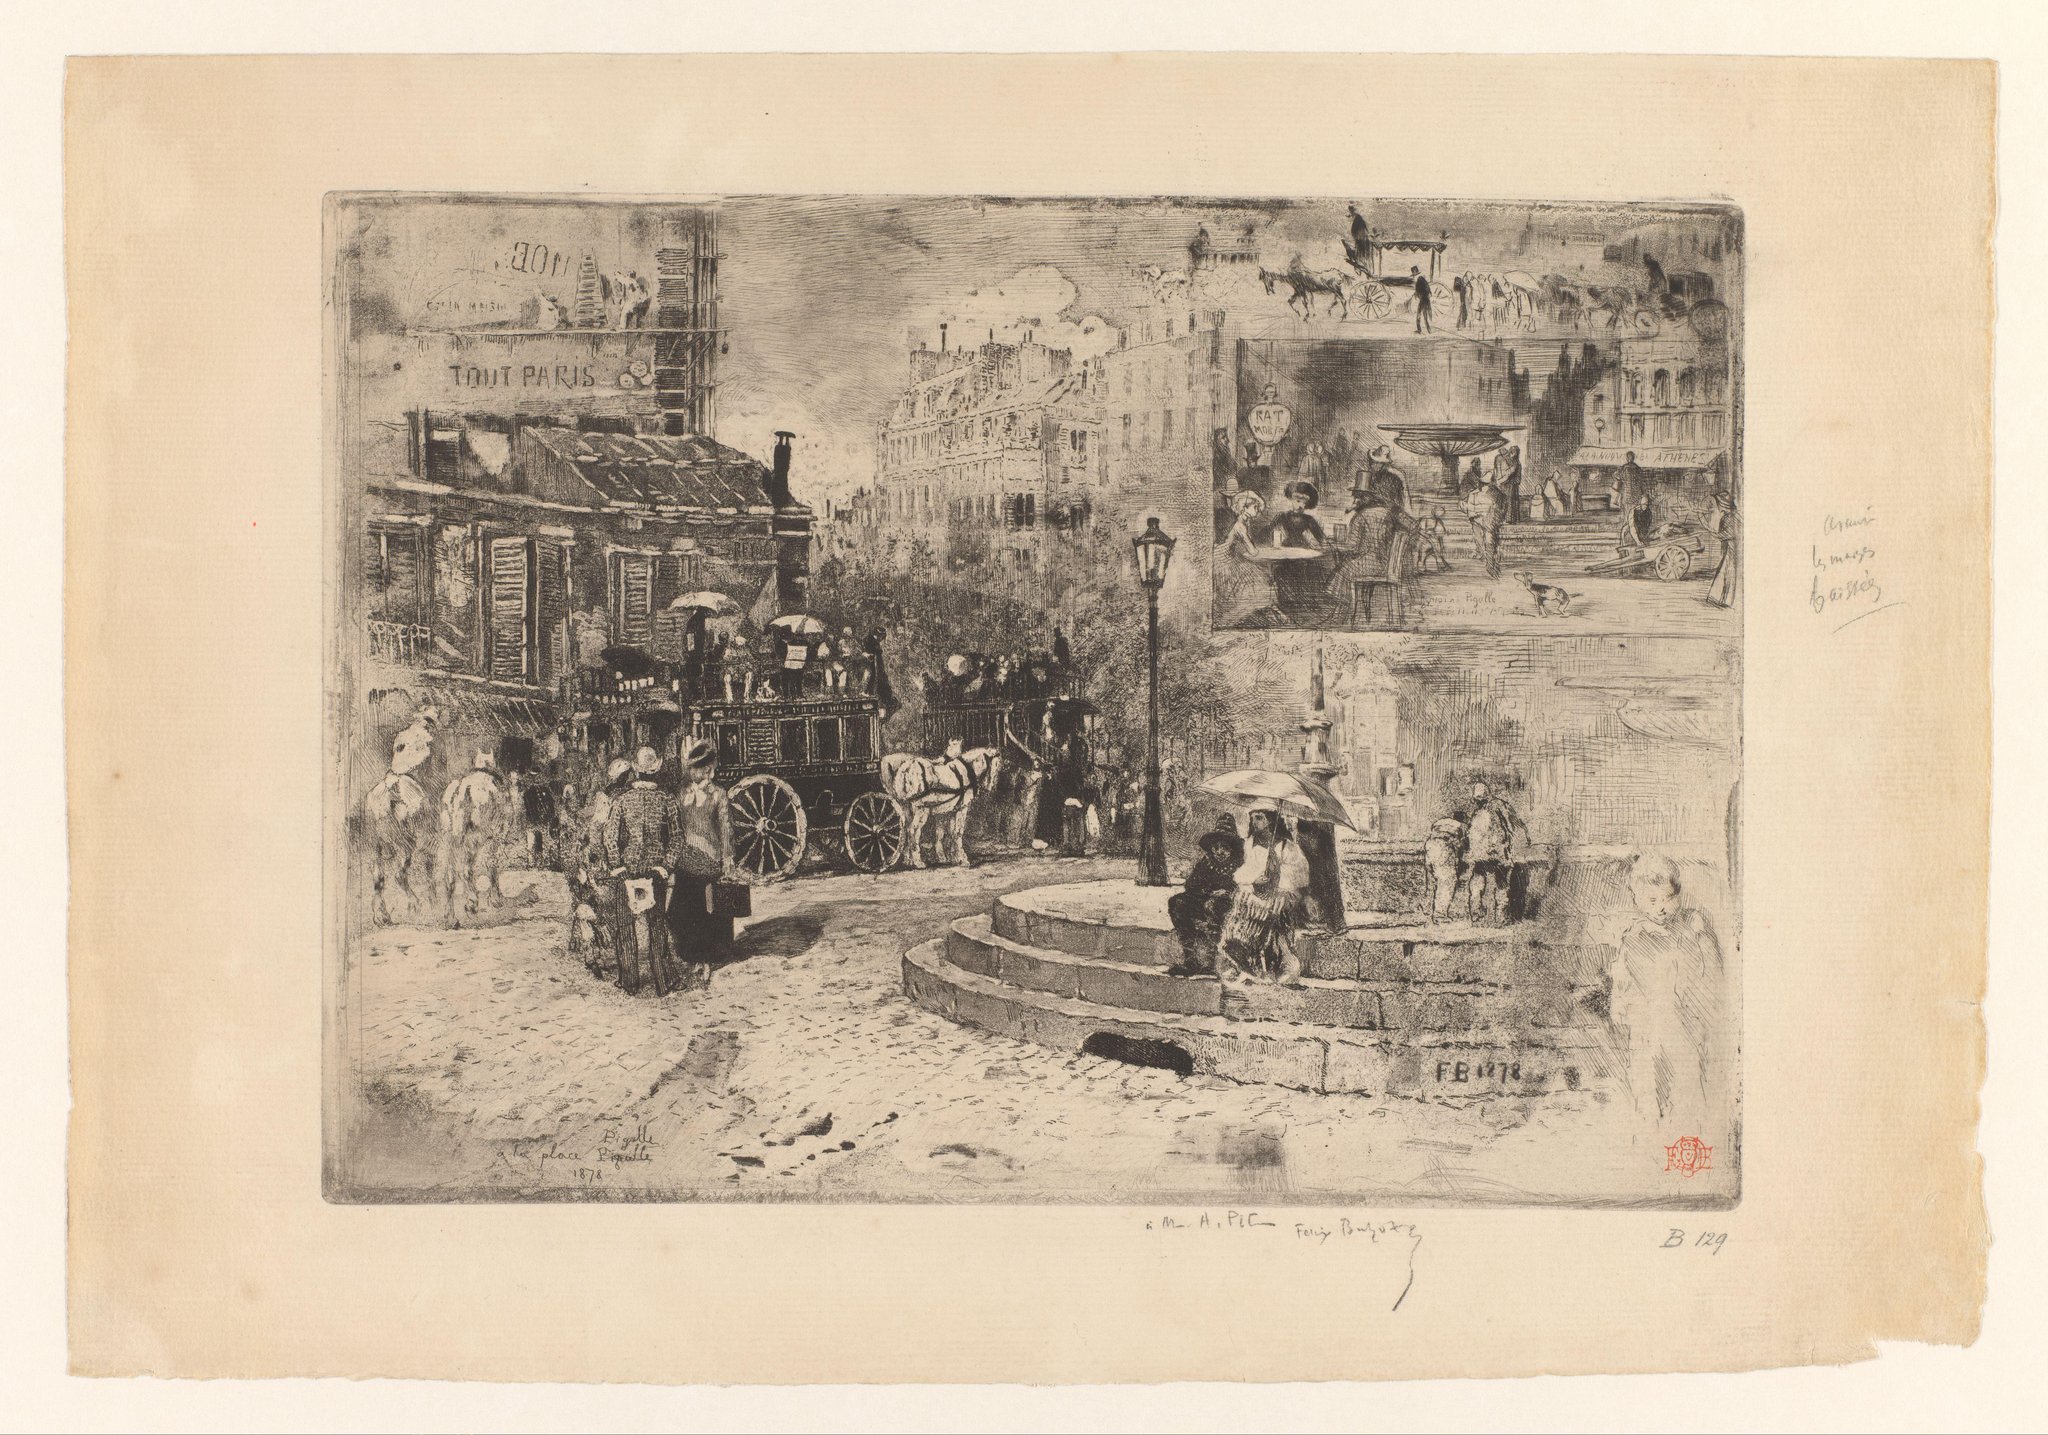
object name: print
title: Gezicht op de Place Pigalle in Parijs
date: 1878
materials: paper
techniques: aquatint, drypoint, etching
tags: city-view, and landscape with man-made constructions, four-wheeled, animal-drawn vehicle, e.g.: cab, carriage, coach, umbrella, ornamental fountain, street lighting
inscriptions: collector's mark: Lugt 977, signature: ‘à A. Pit Felix Buhot’, : ‘(...) les mass baissée’, collector's mark: Lugt 2233